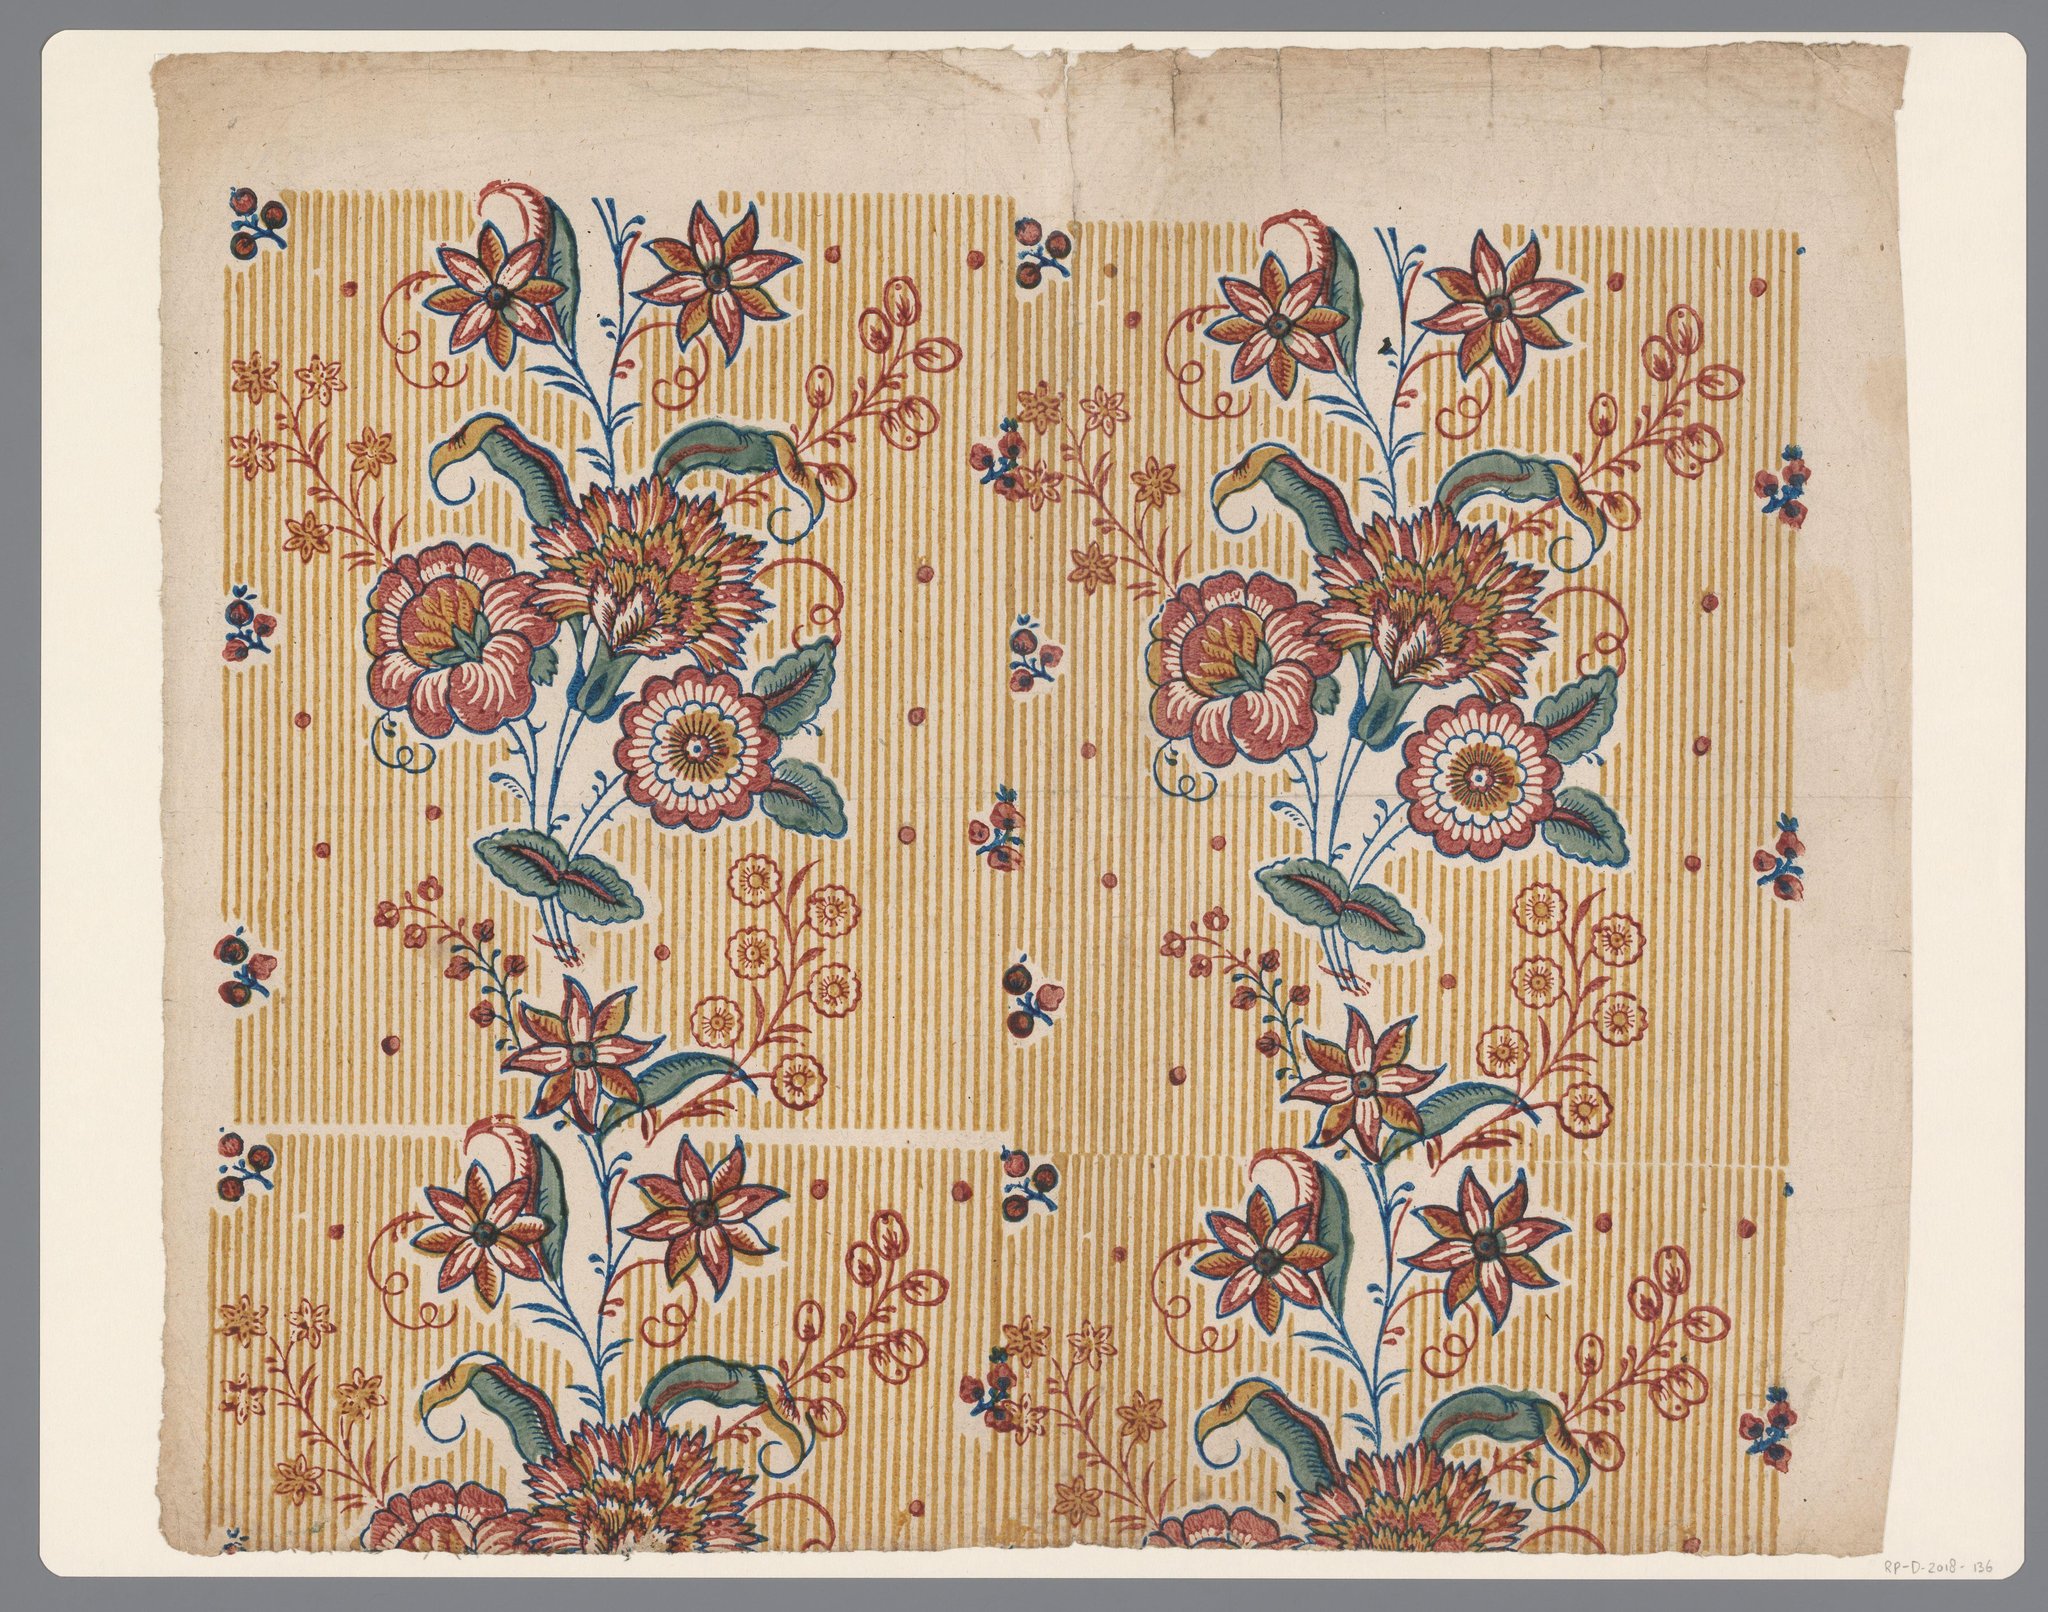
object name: printed paper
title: Blad met banenpatroon van bloemen op strepenfond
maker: Anonymous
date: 1700-1850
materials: paper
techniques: printing block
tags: ornament derived from plant forms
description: Blad met verticaal banenpatroon van bloemranken op onderbroken strepenfond.